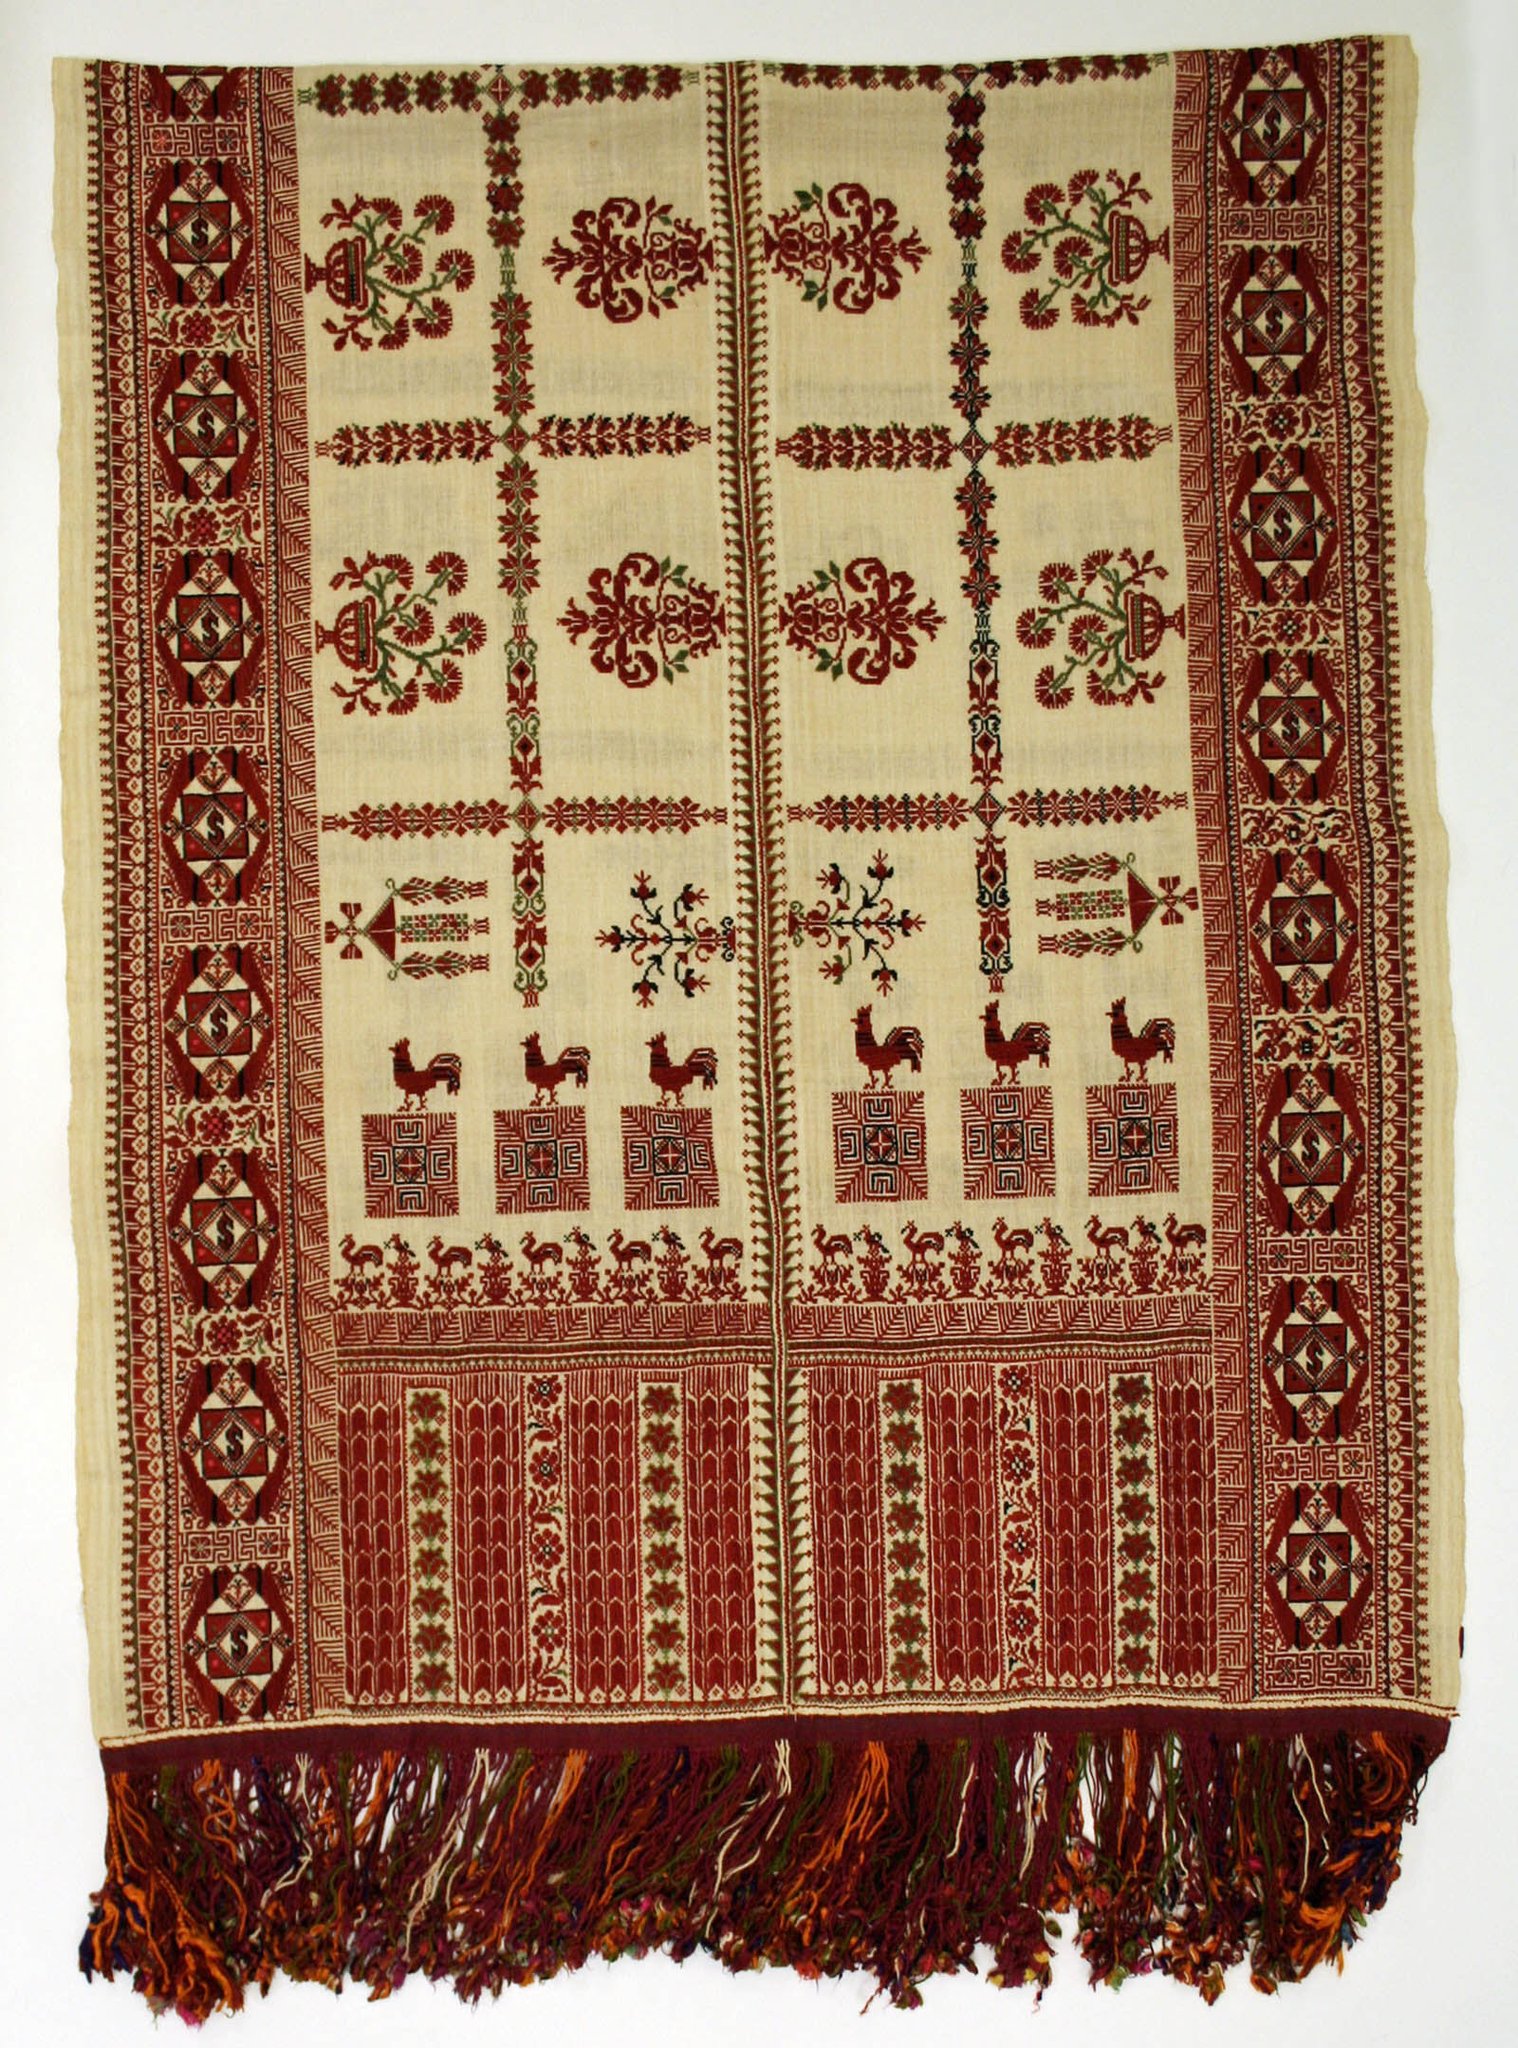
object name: headscarf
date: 1801-1900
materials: linen, silk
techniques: embroidery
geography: palestine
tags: birds